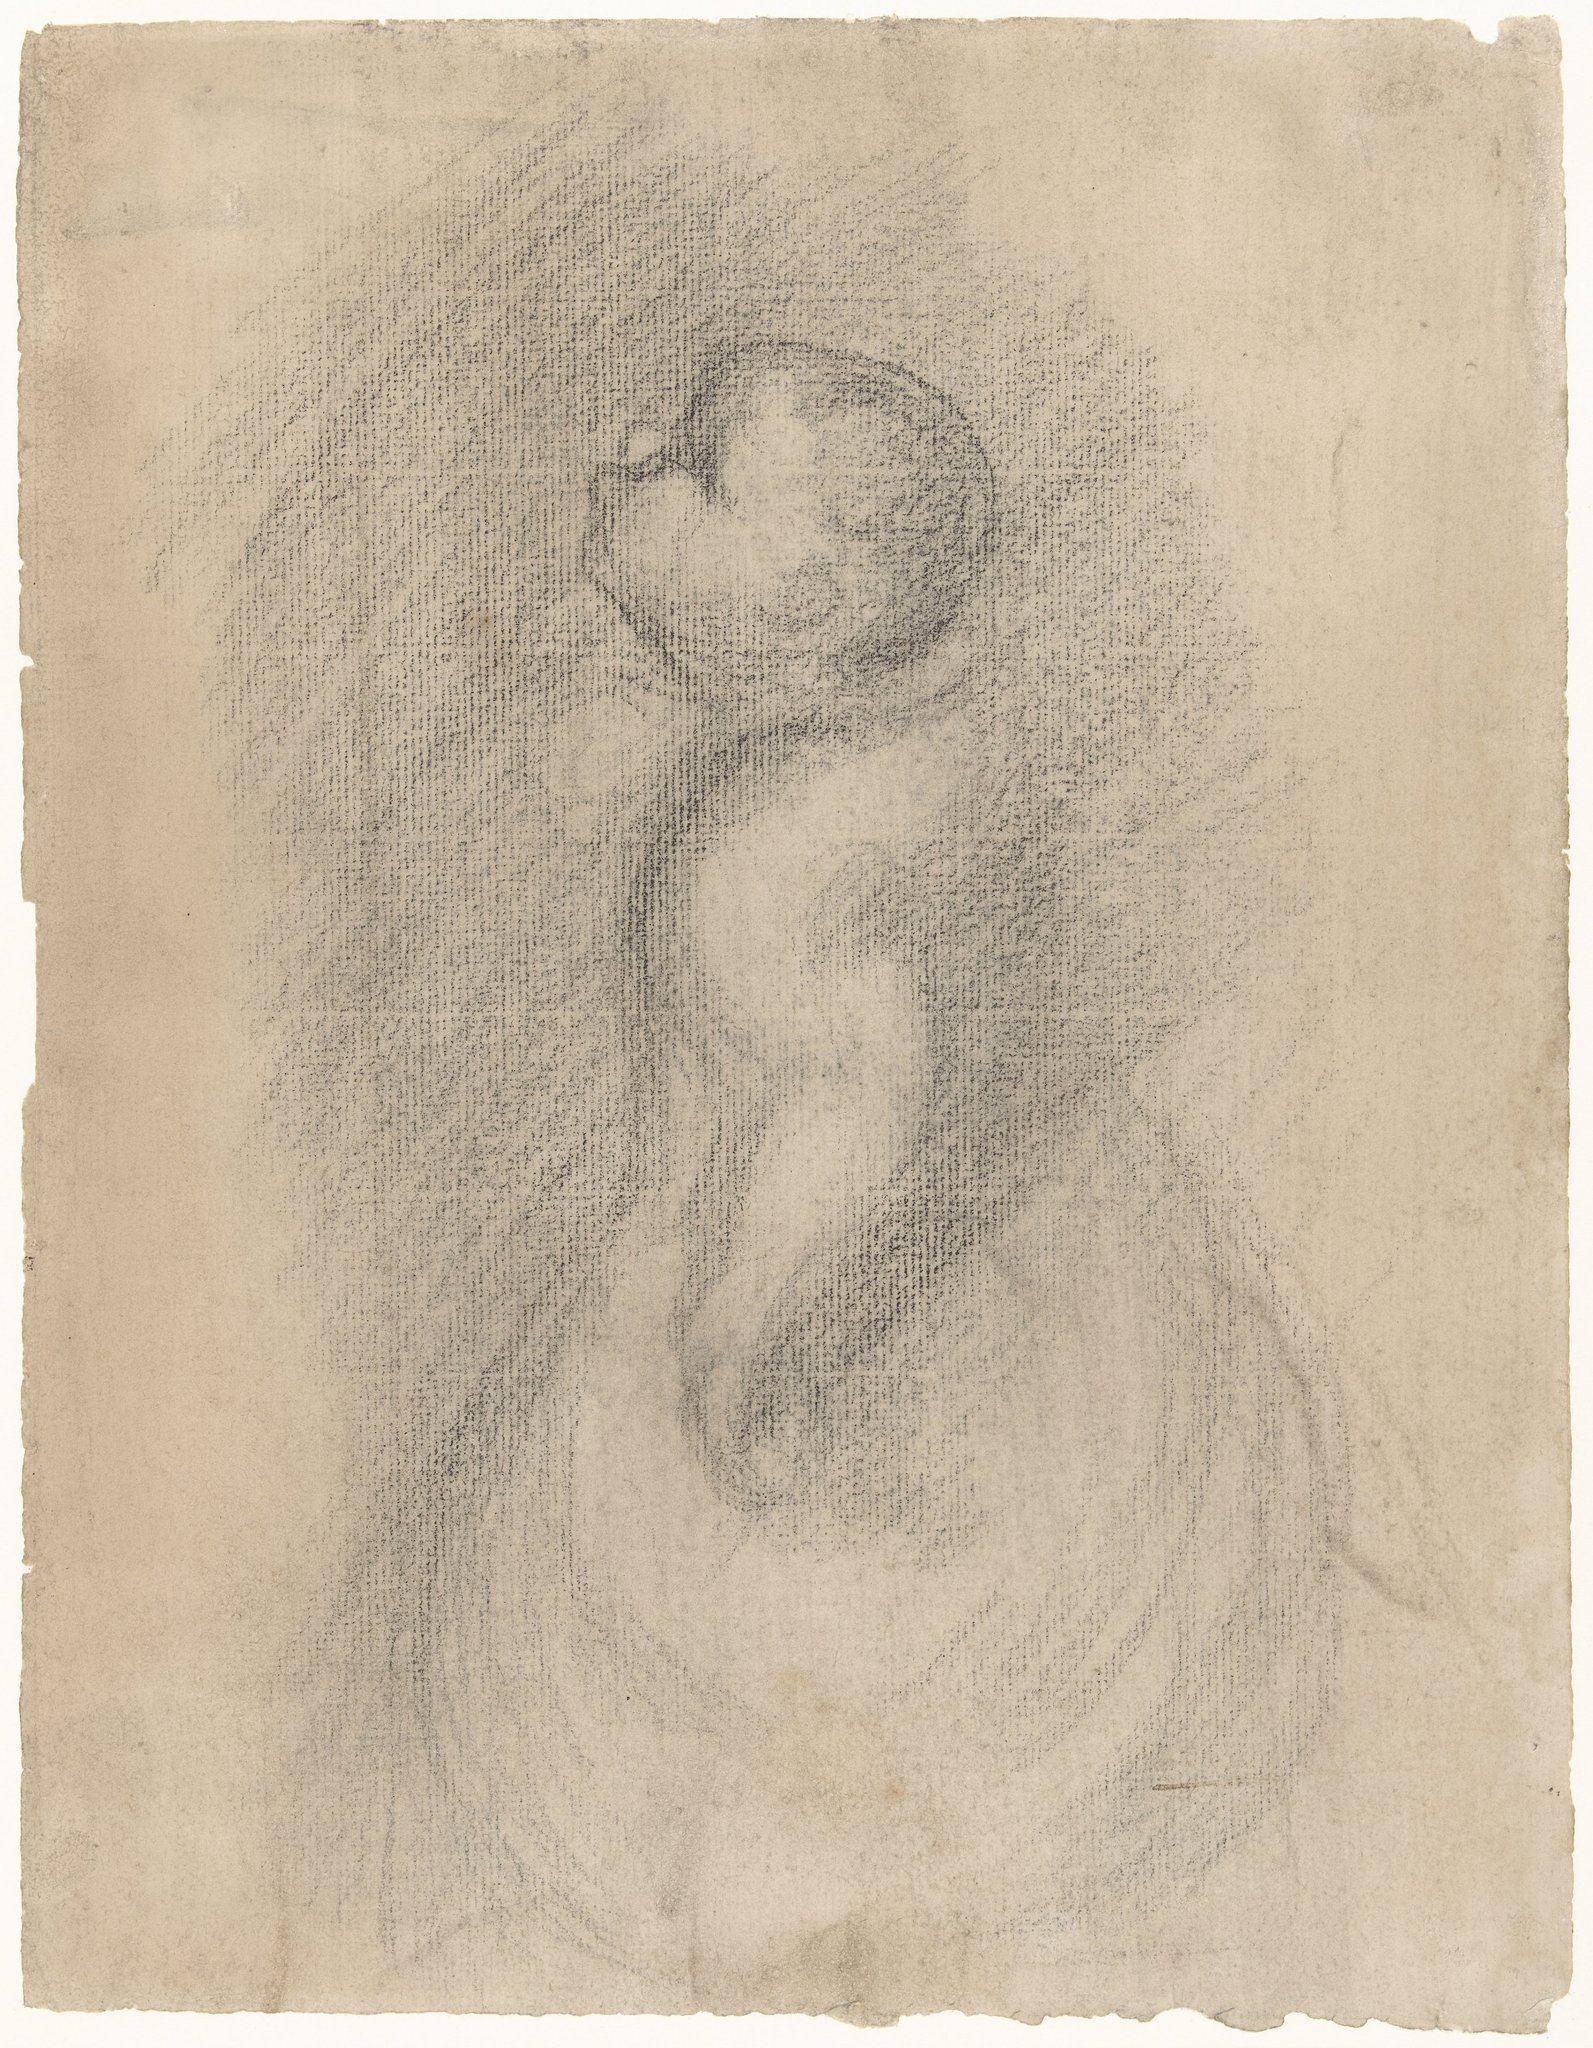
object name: drawing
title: Baby, van opzij gezien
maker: eugène carrière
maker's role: draughtsman, print maker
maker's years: 1849-1906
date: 1859-1906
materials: chalk, paper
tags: infant, baby